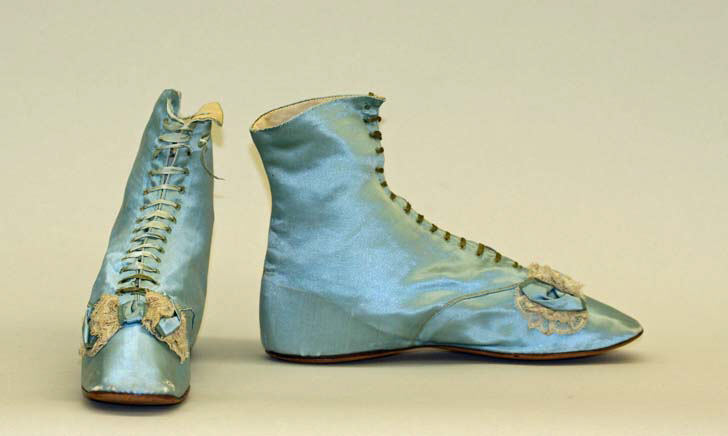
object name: shoe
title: Shoes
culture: french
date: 1850-1859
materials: leather, linen, silk